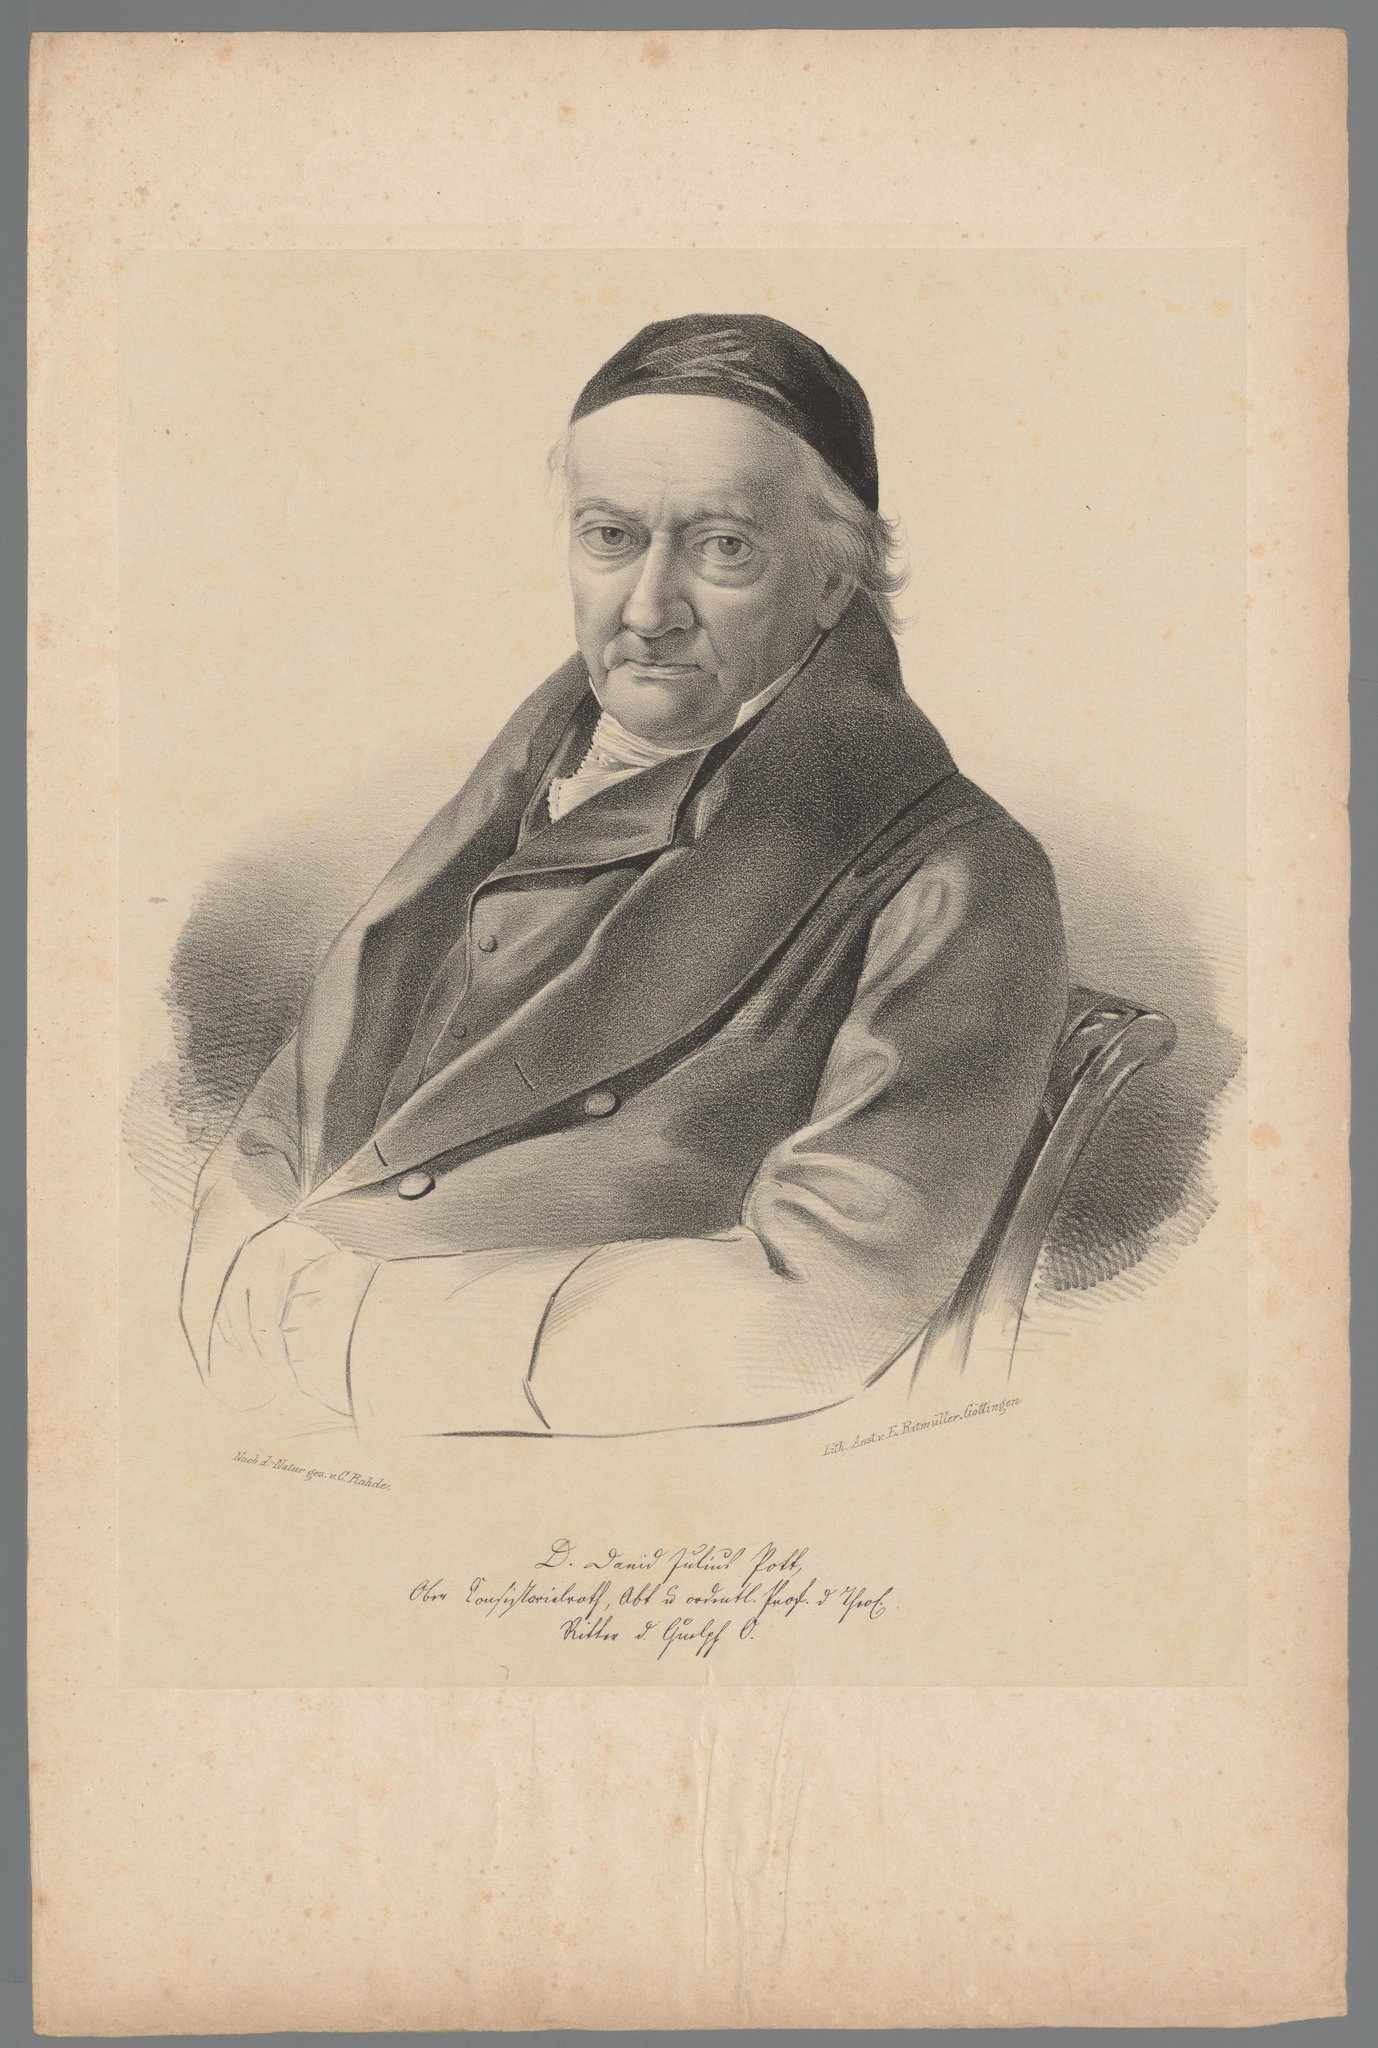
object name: print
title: Portret van David Julius Pott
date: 1816-1868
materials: paper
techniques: lithograph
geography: gottingen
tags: theologian, historical persons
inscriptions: collector's mark: Lugt 2228